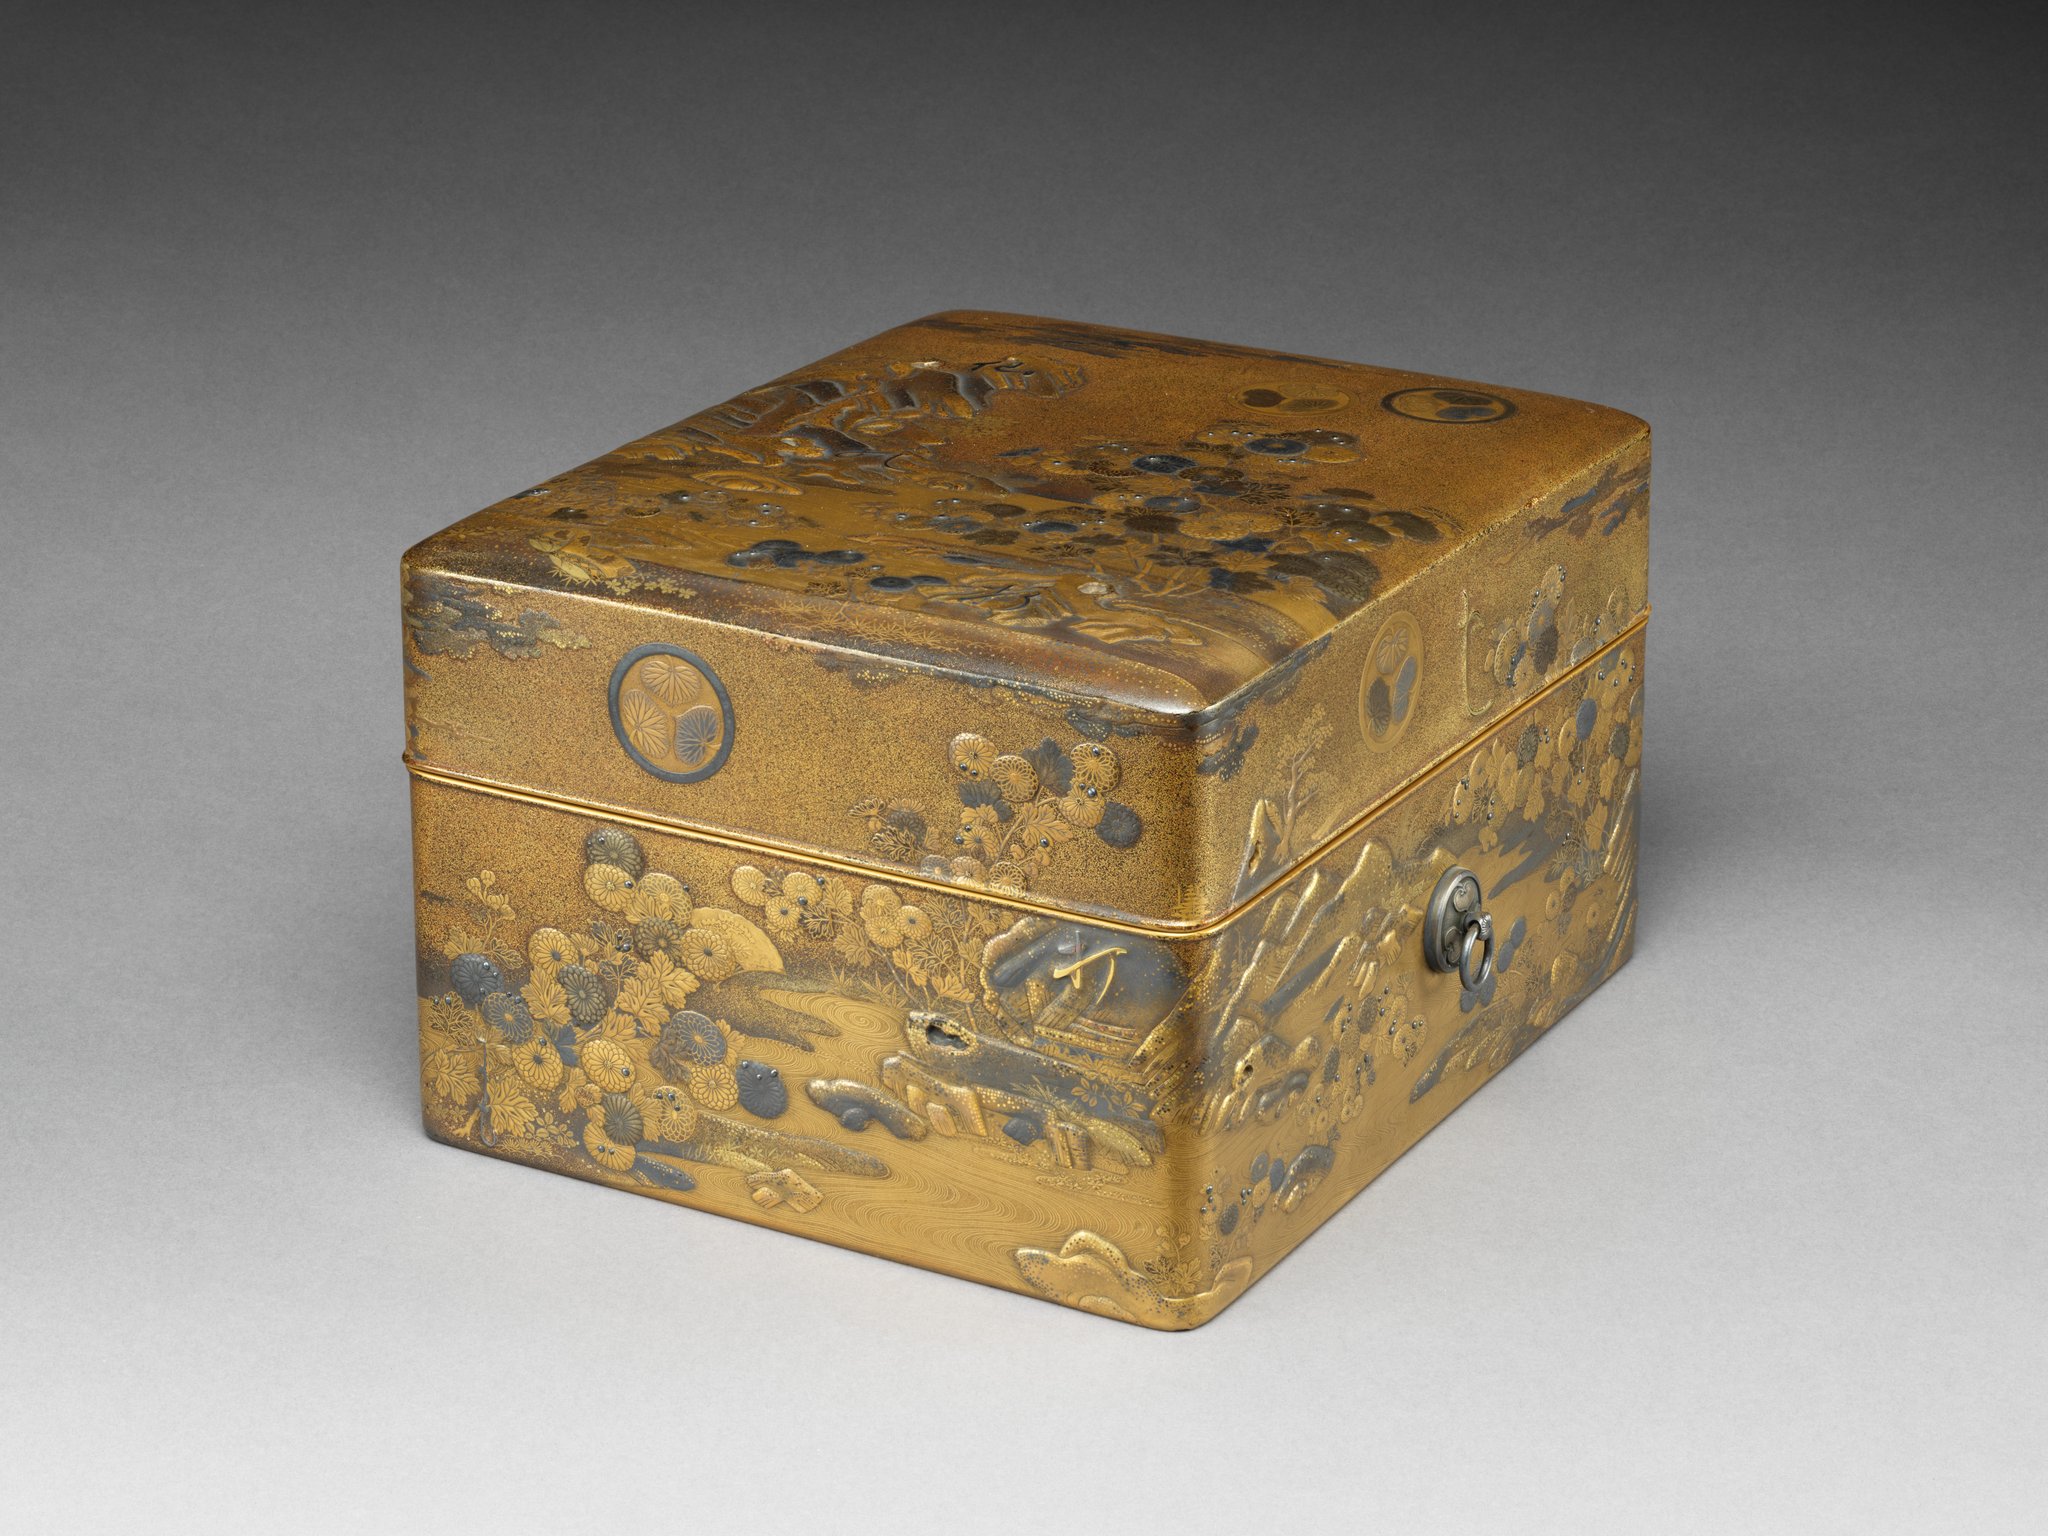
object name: box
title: Box for Personal Accessories (Tebako) with Decoration Based on a Poem from the Shinkokinshū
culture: japanese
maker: kōami chōjū (nagashige)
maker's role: artist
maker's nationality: japanese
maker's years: 1599-1651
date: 1633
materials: gold, silver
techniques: maki